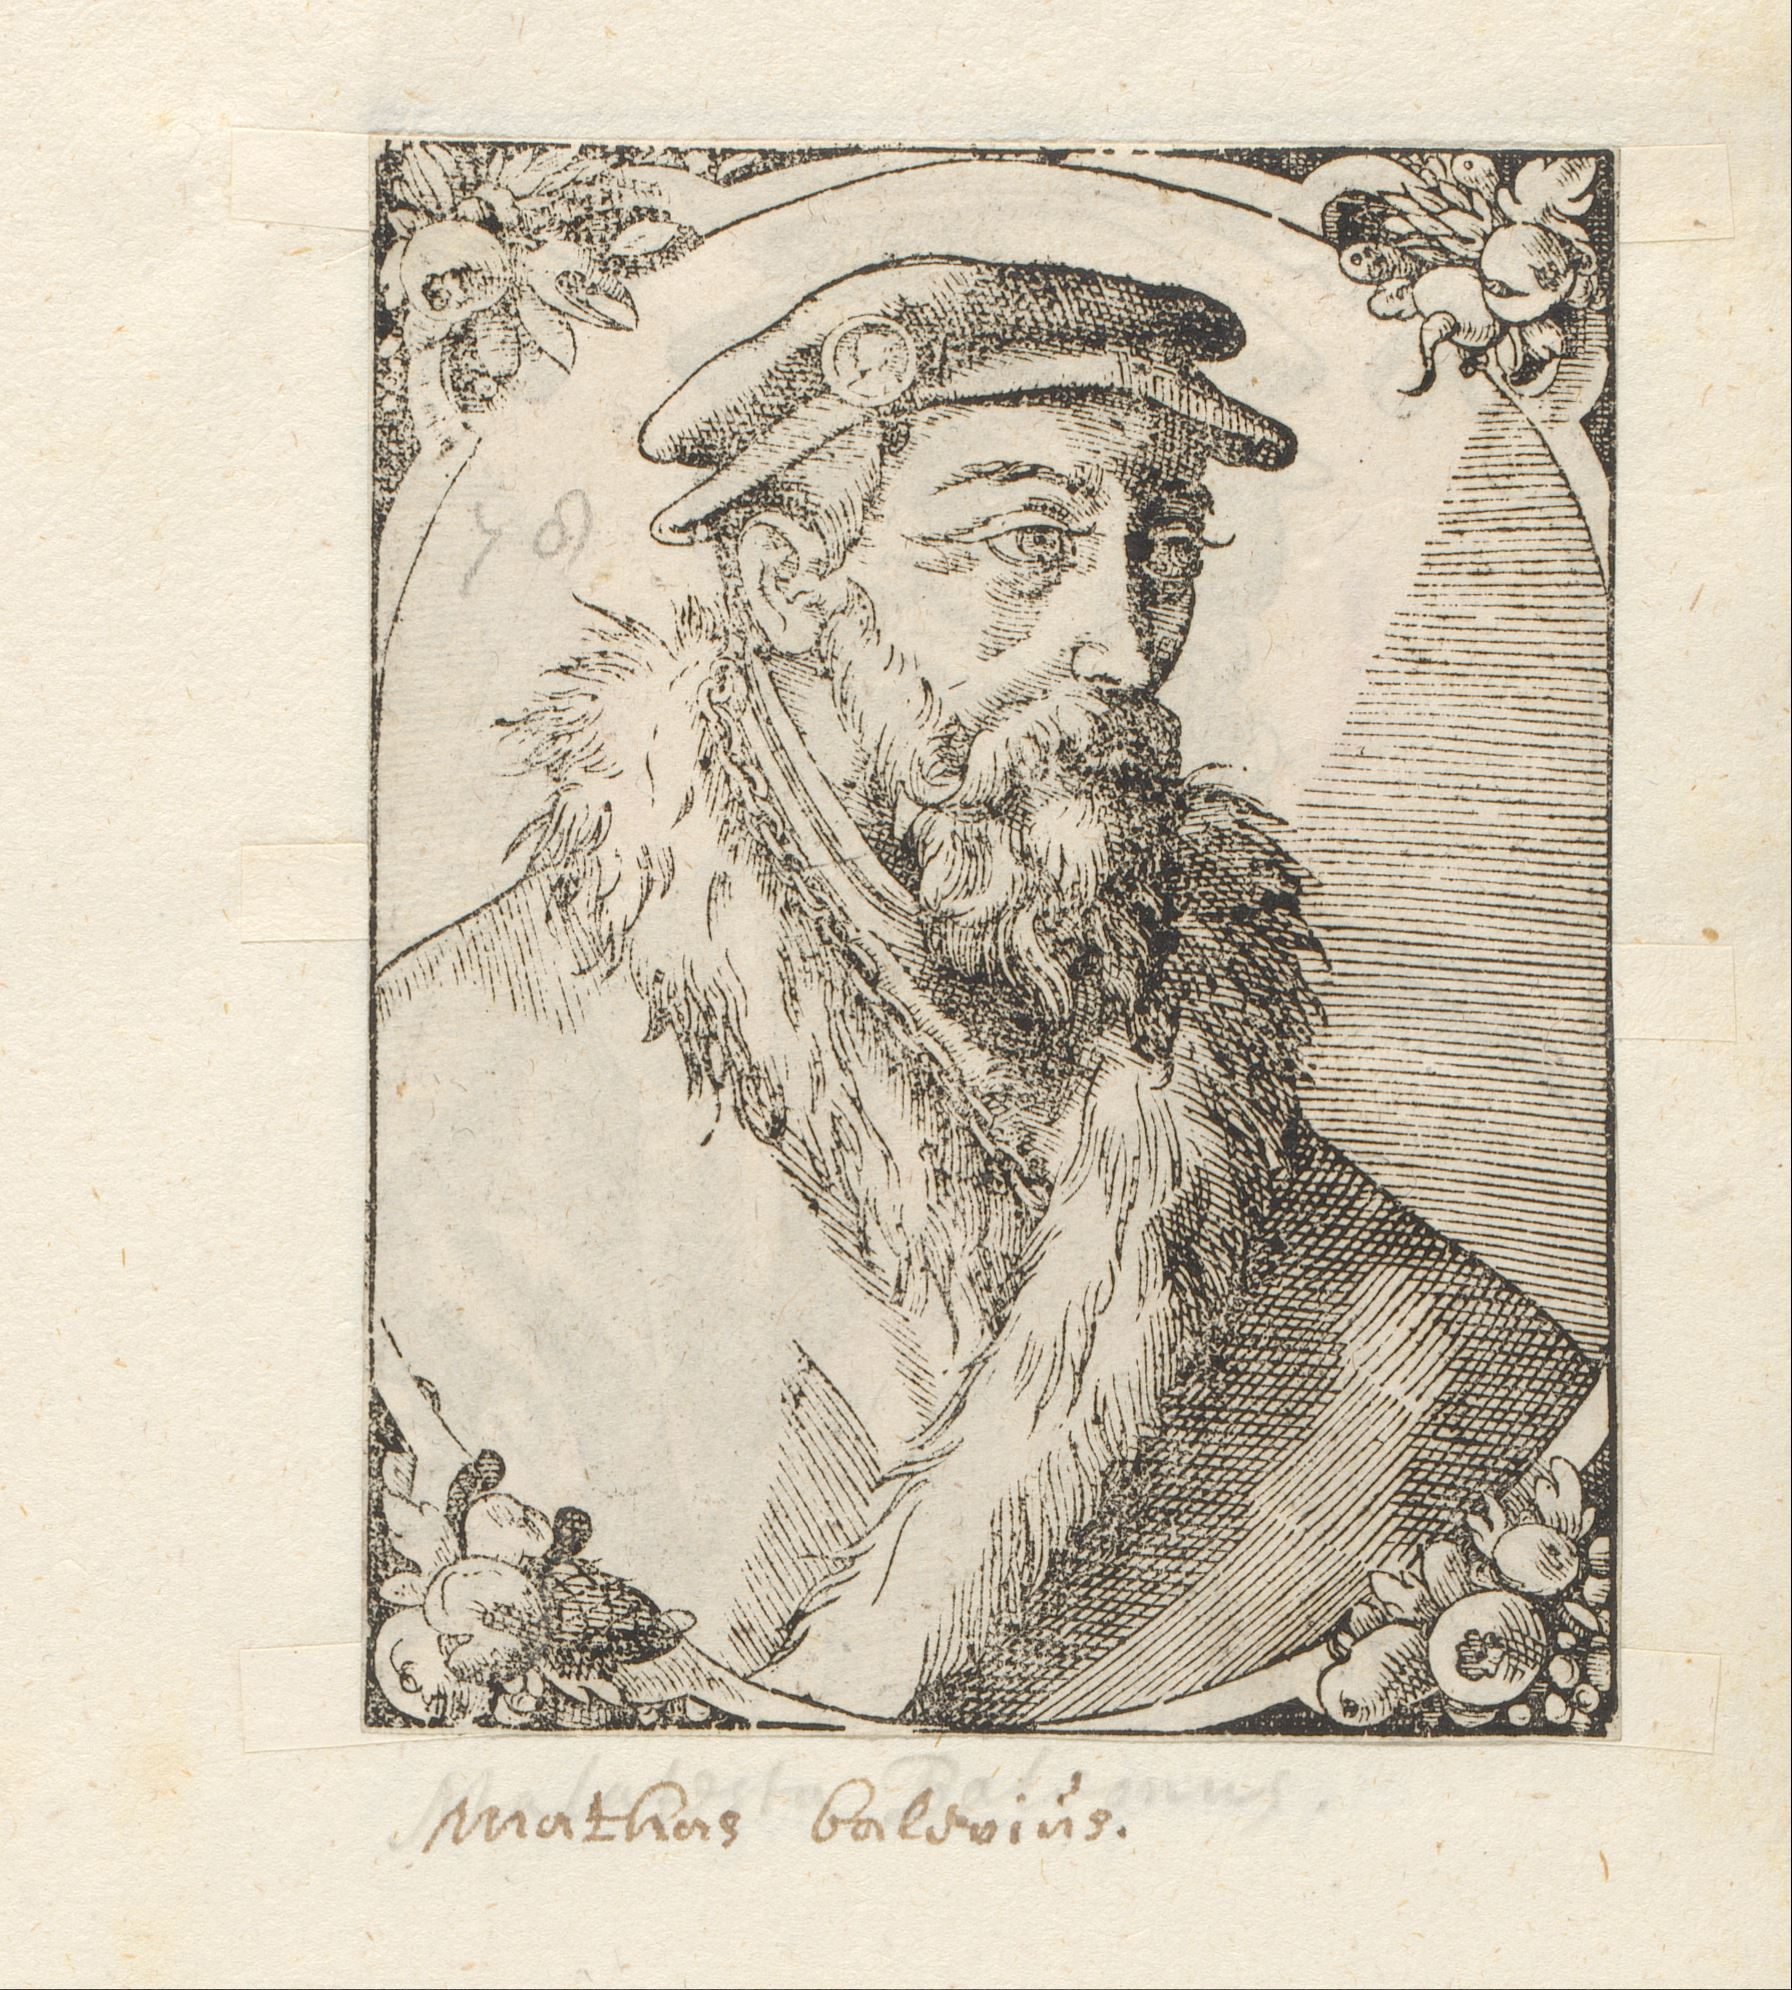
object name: print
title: Portret van Malatesta Baglioni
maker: Anonymous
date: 1549-1575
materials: paper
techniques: woodcut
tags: commander-in-chief, general, marshal, historical persons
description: Prent gebruikt in: Giovio, Paolo. Elogia Virorum bellica virtute illustrium (...). Bazel: Peter Perna, 1575.